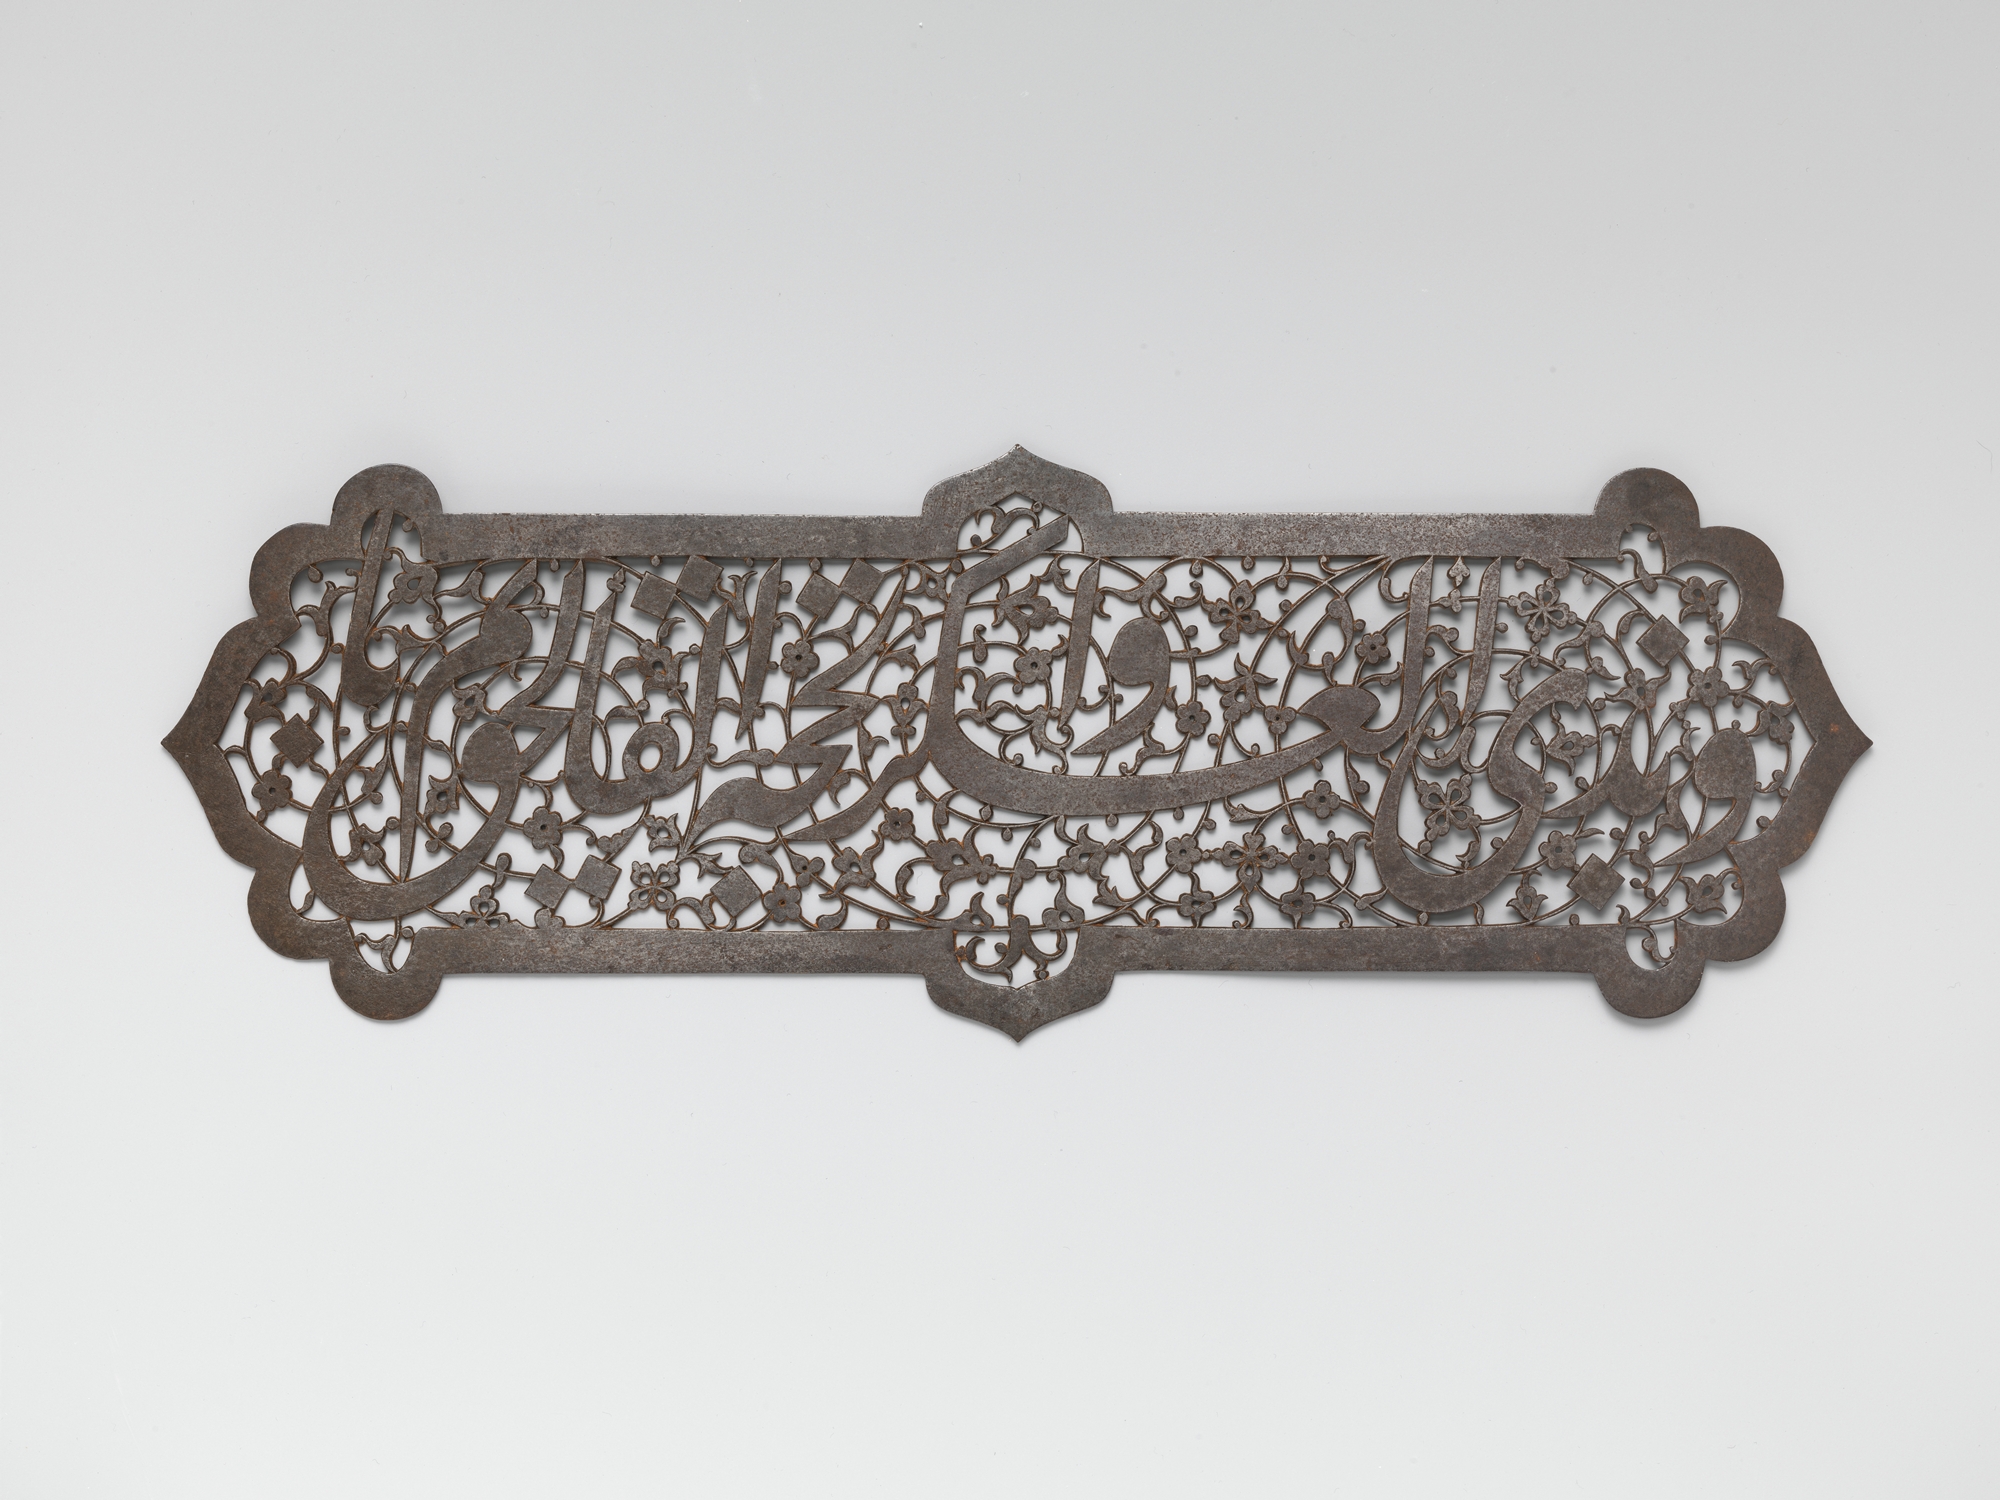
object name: plaque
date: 1601-1700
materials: steel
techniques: cutting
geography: iran